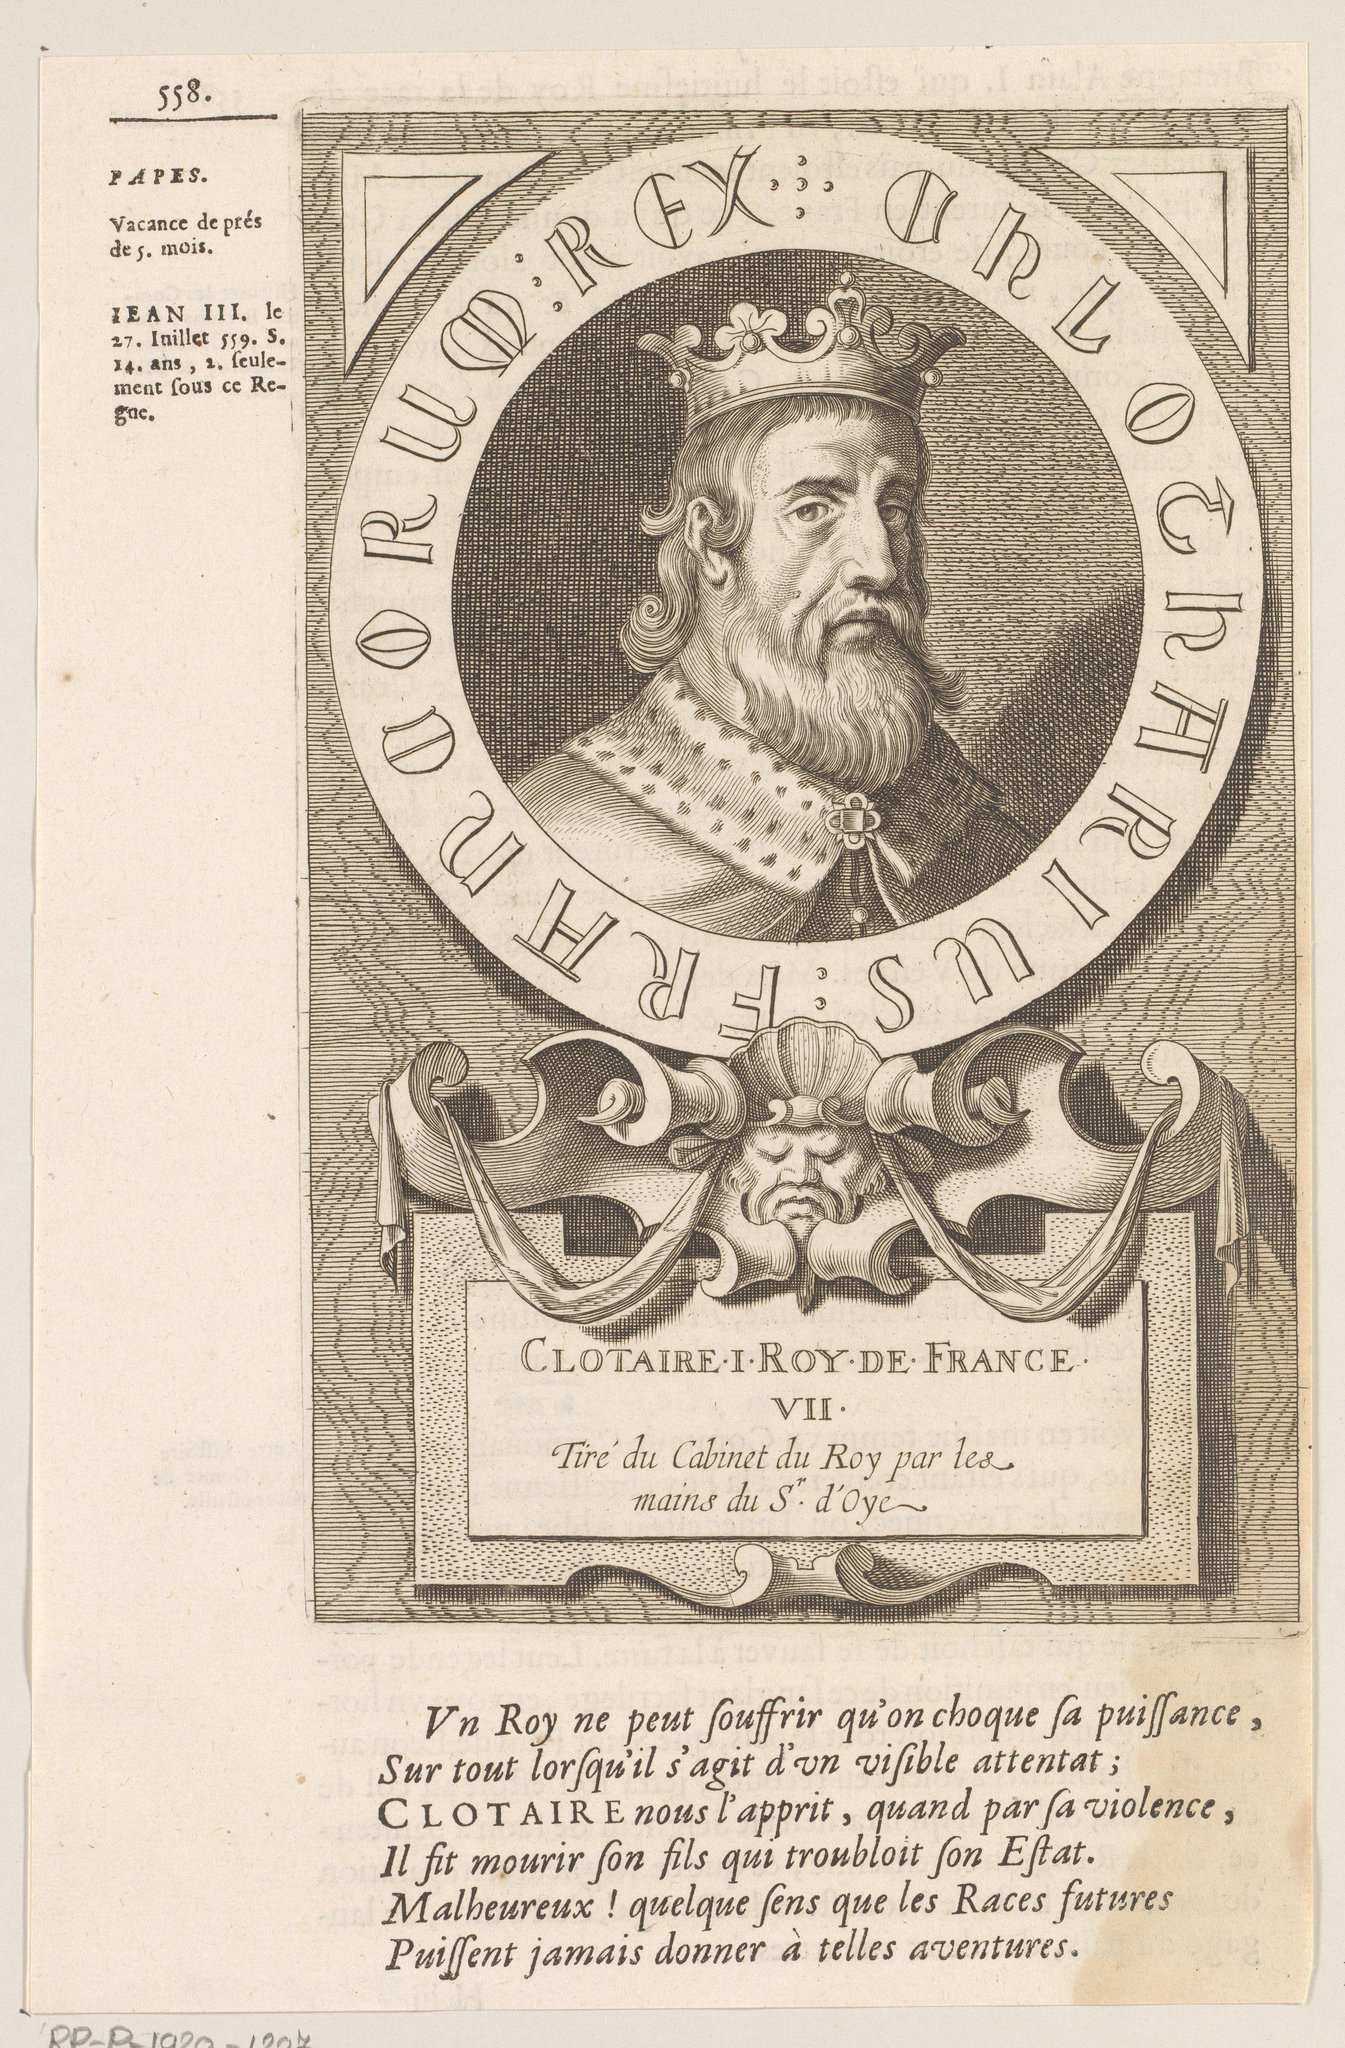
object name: print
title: Clotaire I roy de France VII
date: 1635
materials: paper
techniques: engraving, letterpress printing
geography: paris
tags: historical persons, ruler, sovereign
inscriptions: collector's mark: Lugt 2228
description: Prent uit: Eudes de Mézeray, François. Histoire de France, depuis Faramond jusqu’au regne de Louis le Juste (...). 3 dln. Parijs: Denis Thierry, Jean Guignard en Claude Barbin, 1635, dl. 1. Prent waarschijnlijk voor het eerst verschenen in: Bie, Jacques de. Les vrais portraits des rois de France (...). Parijs: Jacques de Bie en Pierre Rocolet, 1634. Prent ook gebruikt in latere publicaties.